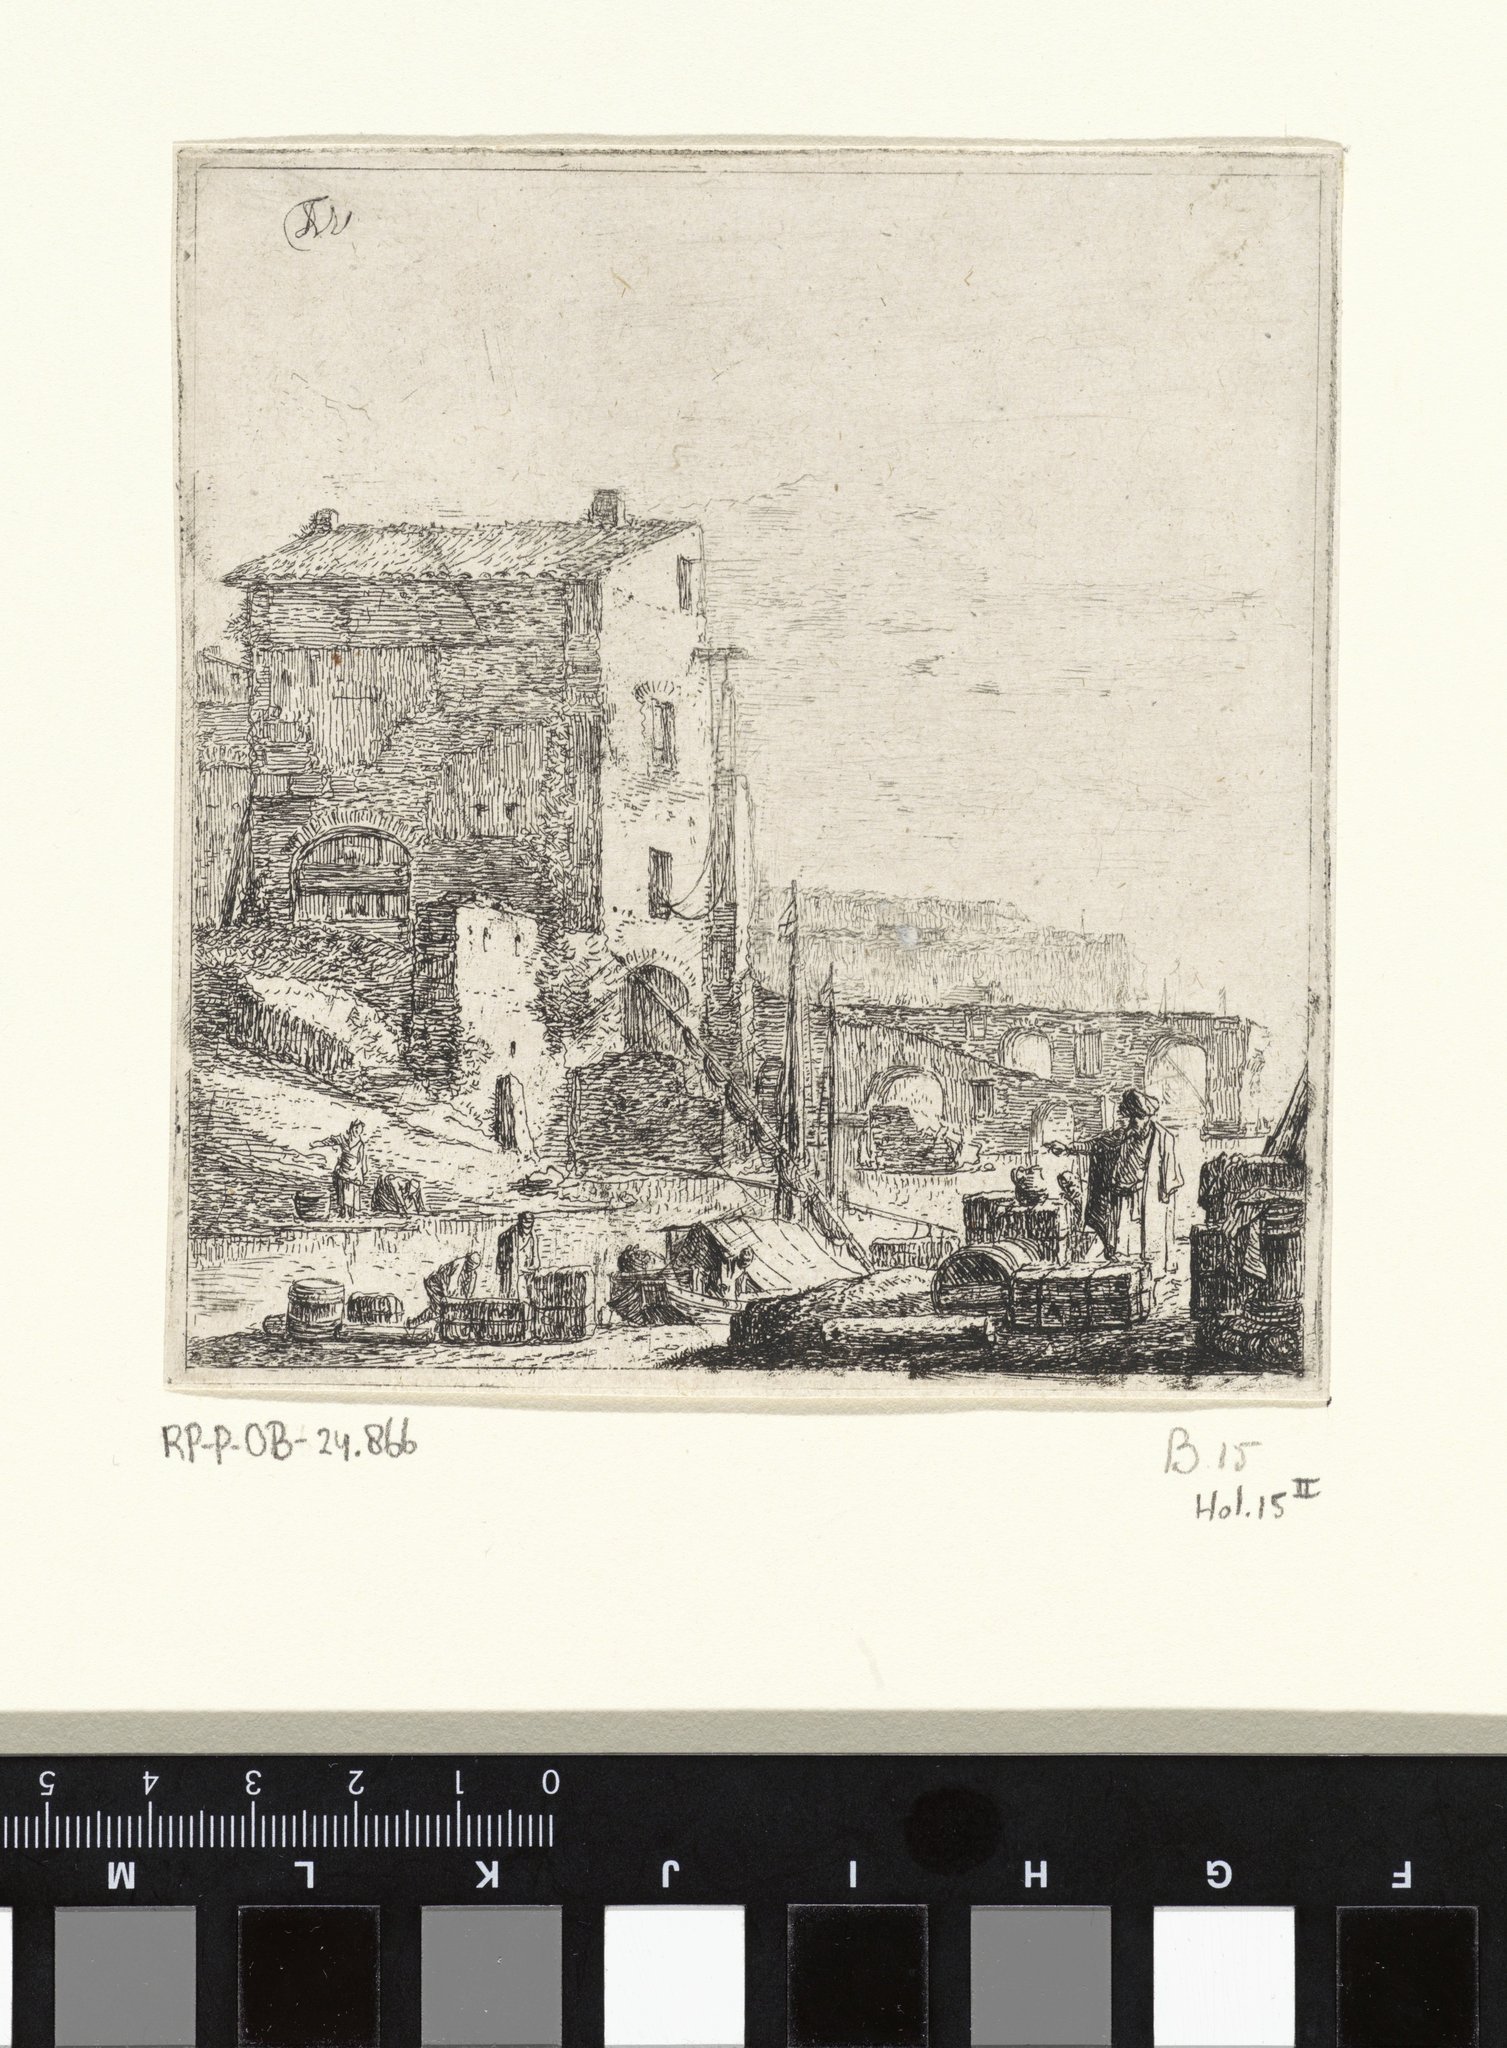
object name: print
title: Oosterse koopman bij een rivier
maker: thomas wijck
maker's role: draughtsman, painter, print maker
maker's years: 1616-1677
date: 1626-1677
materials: paper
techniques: etching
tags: merchant, salesman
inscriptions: collector's mark: Lugt 240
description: Een oosterse koopman staat tussen koopwaar op de kade. Aan de overkant van de rivier een pakhuis.